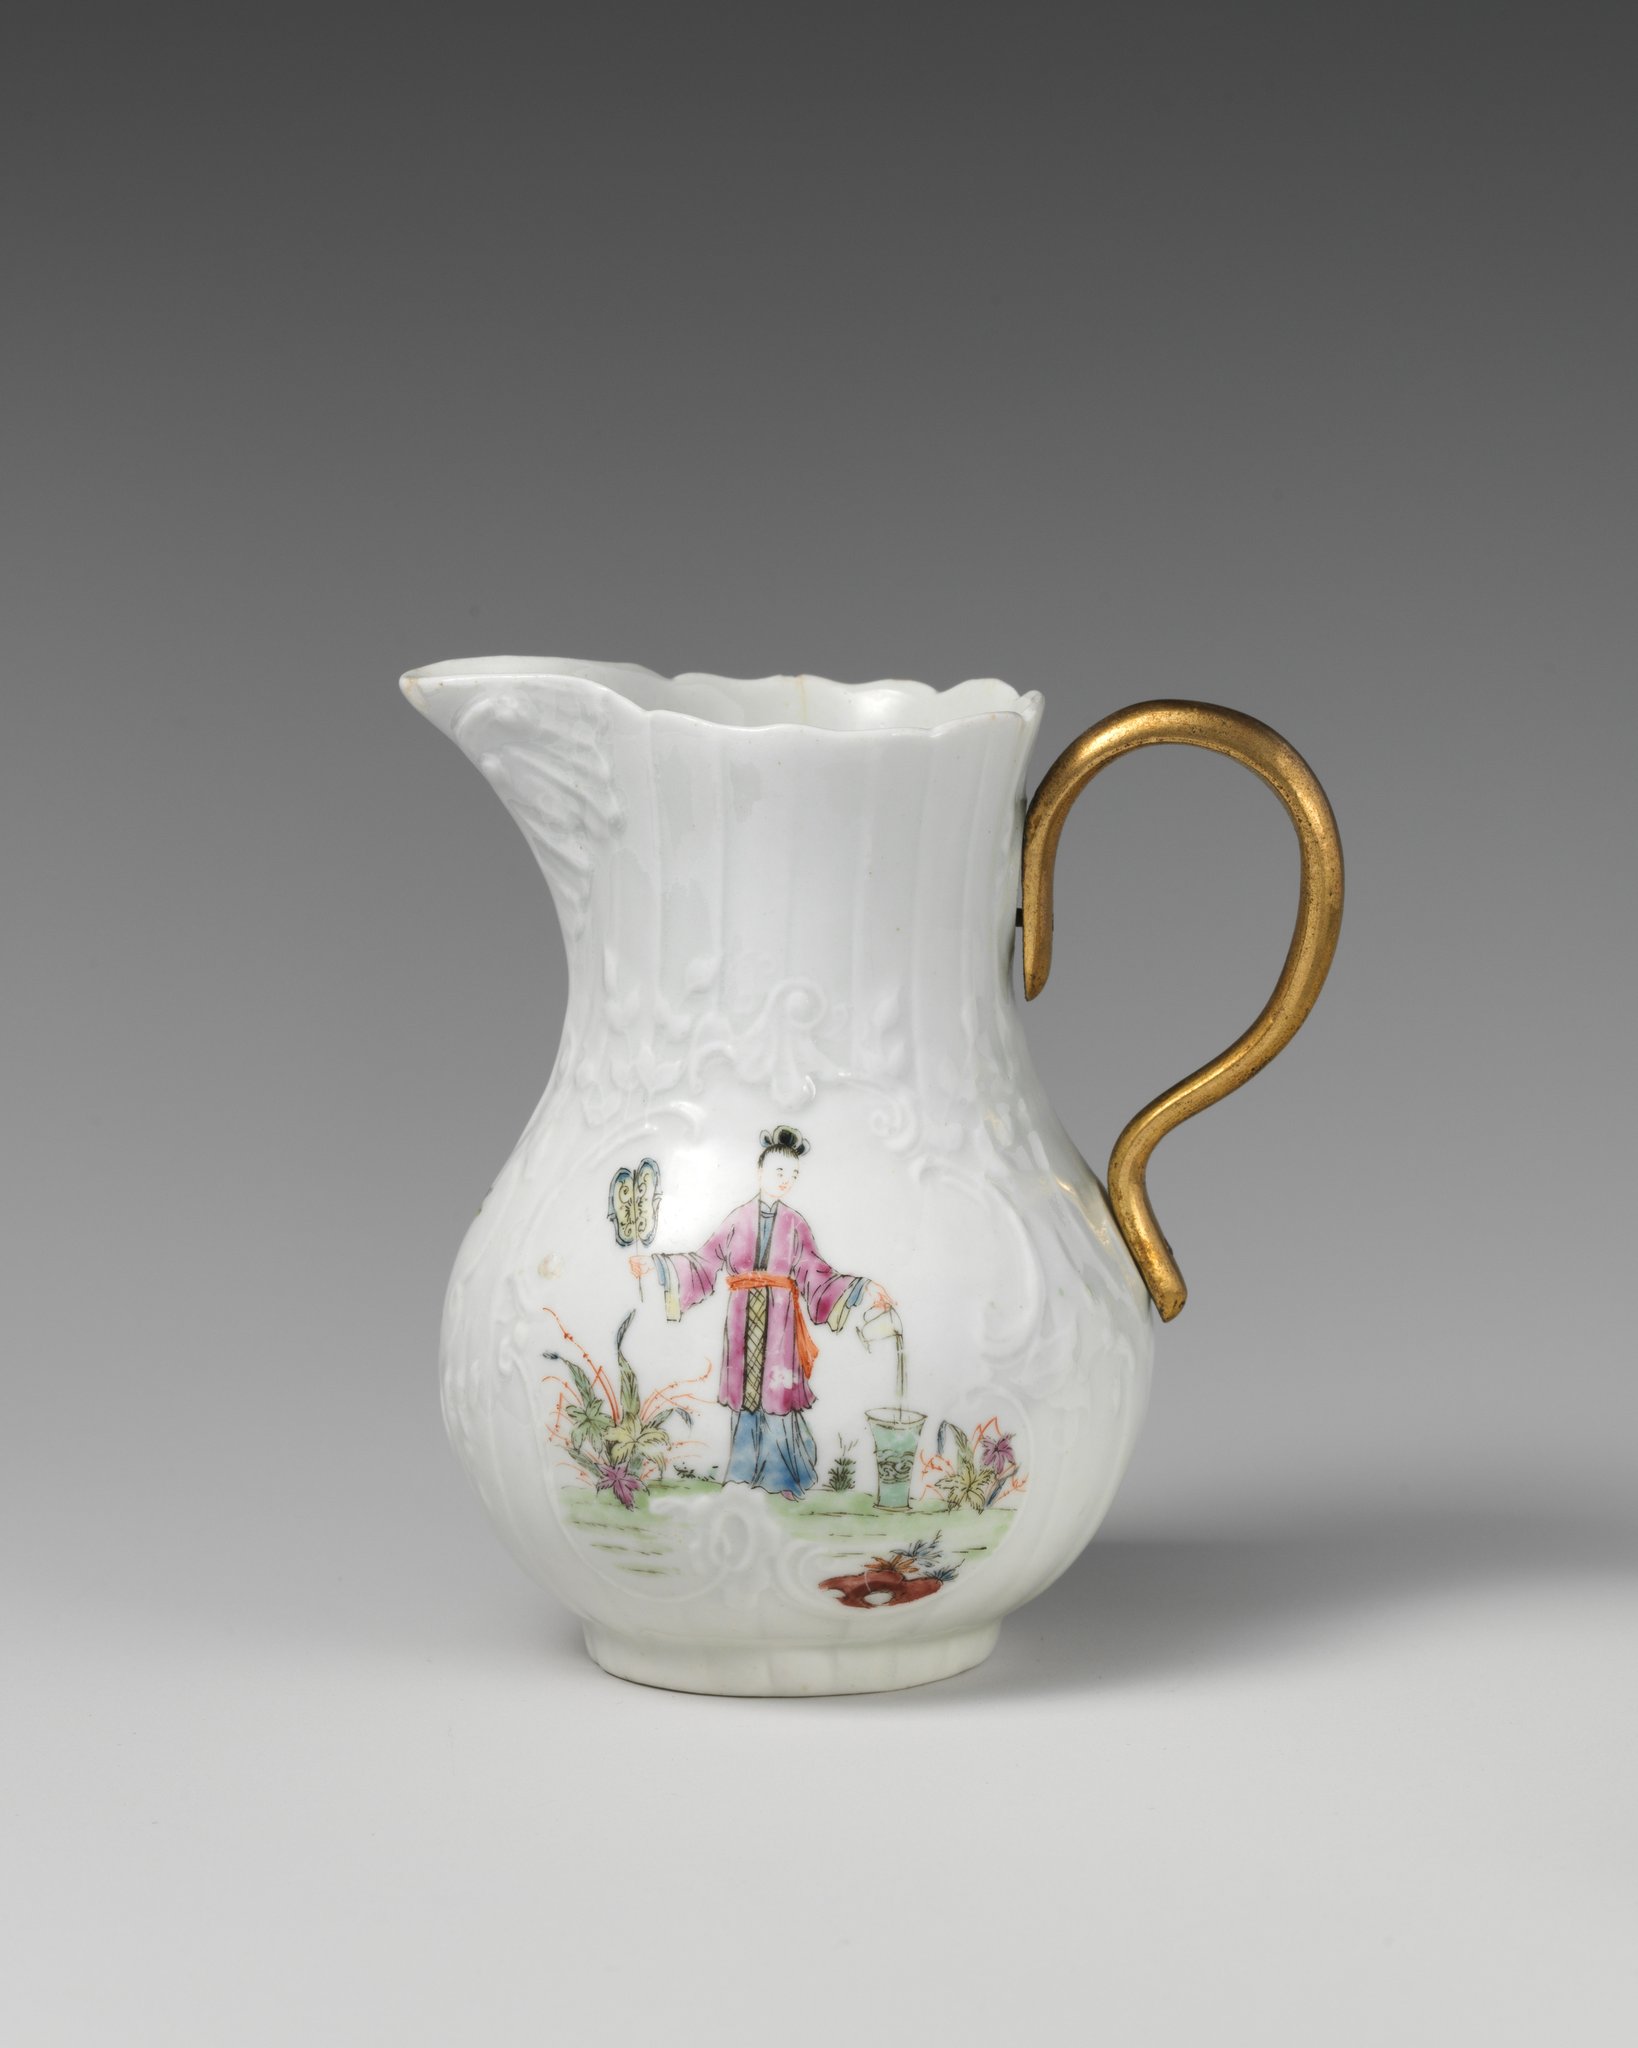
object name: cream jug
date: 1701-1800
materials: metal, soft paste porcelain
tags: women